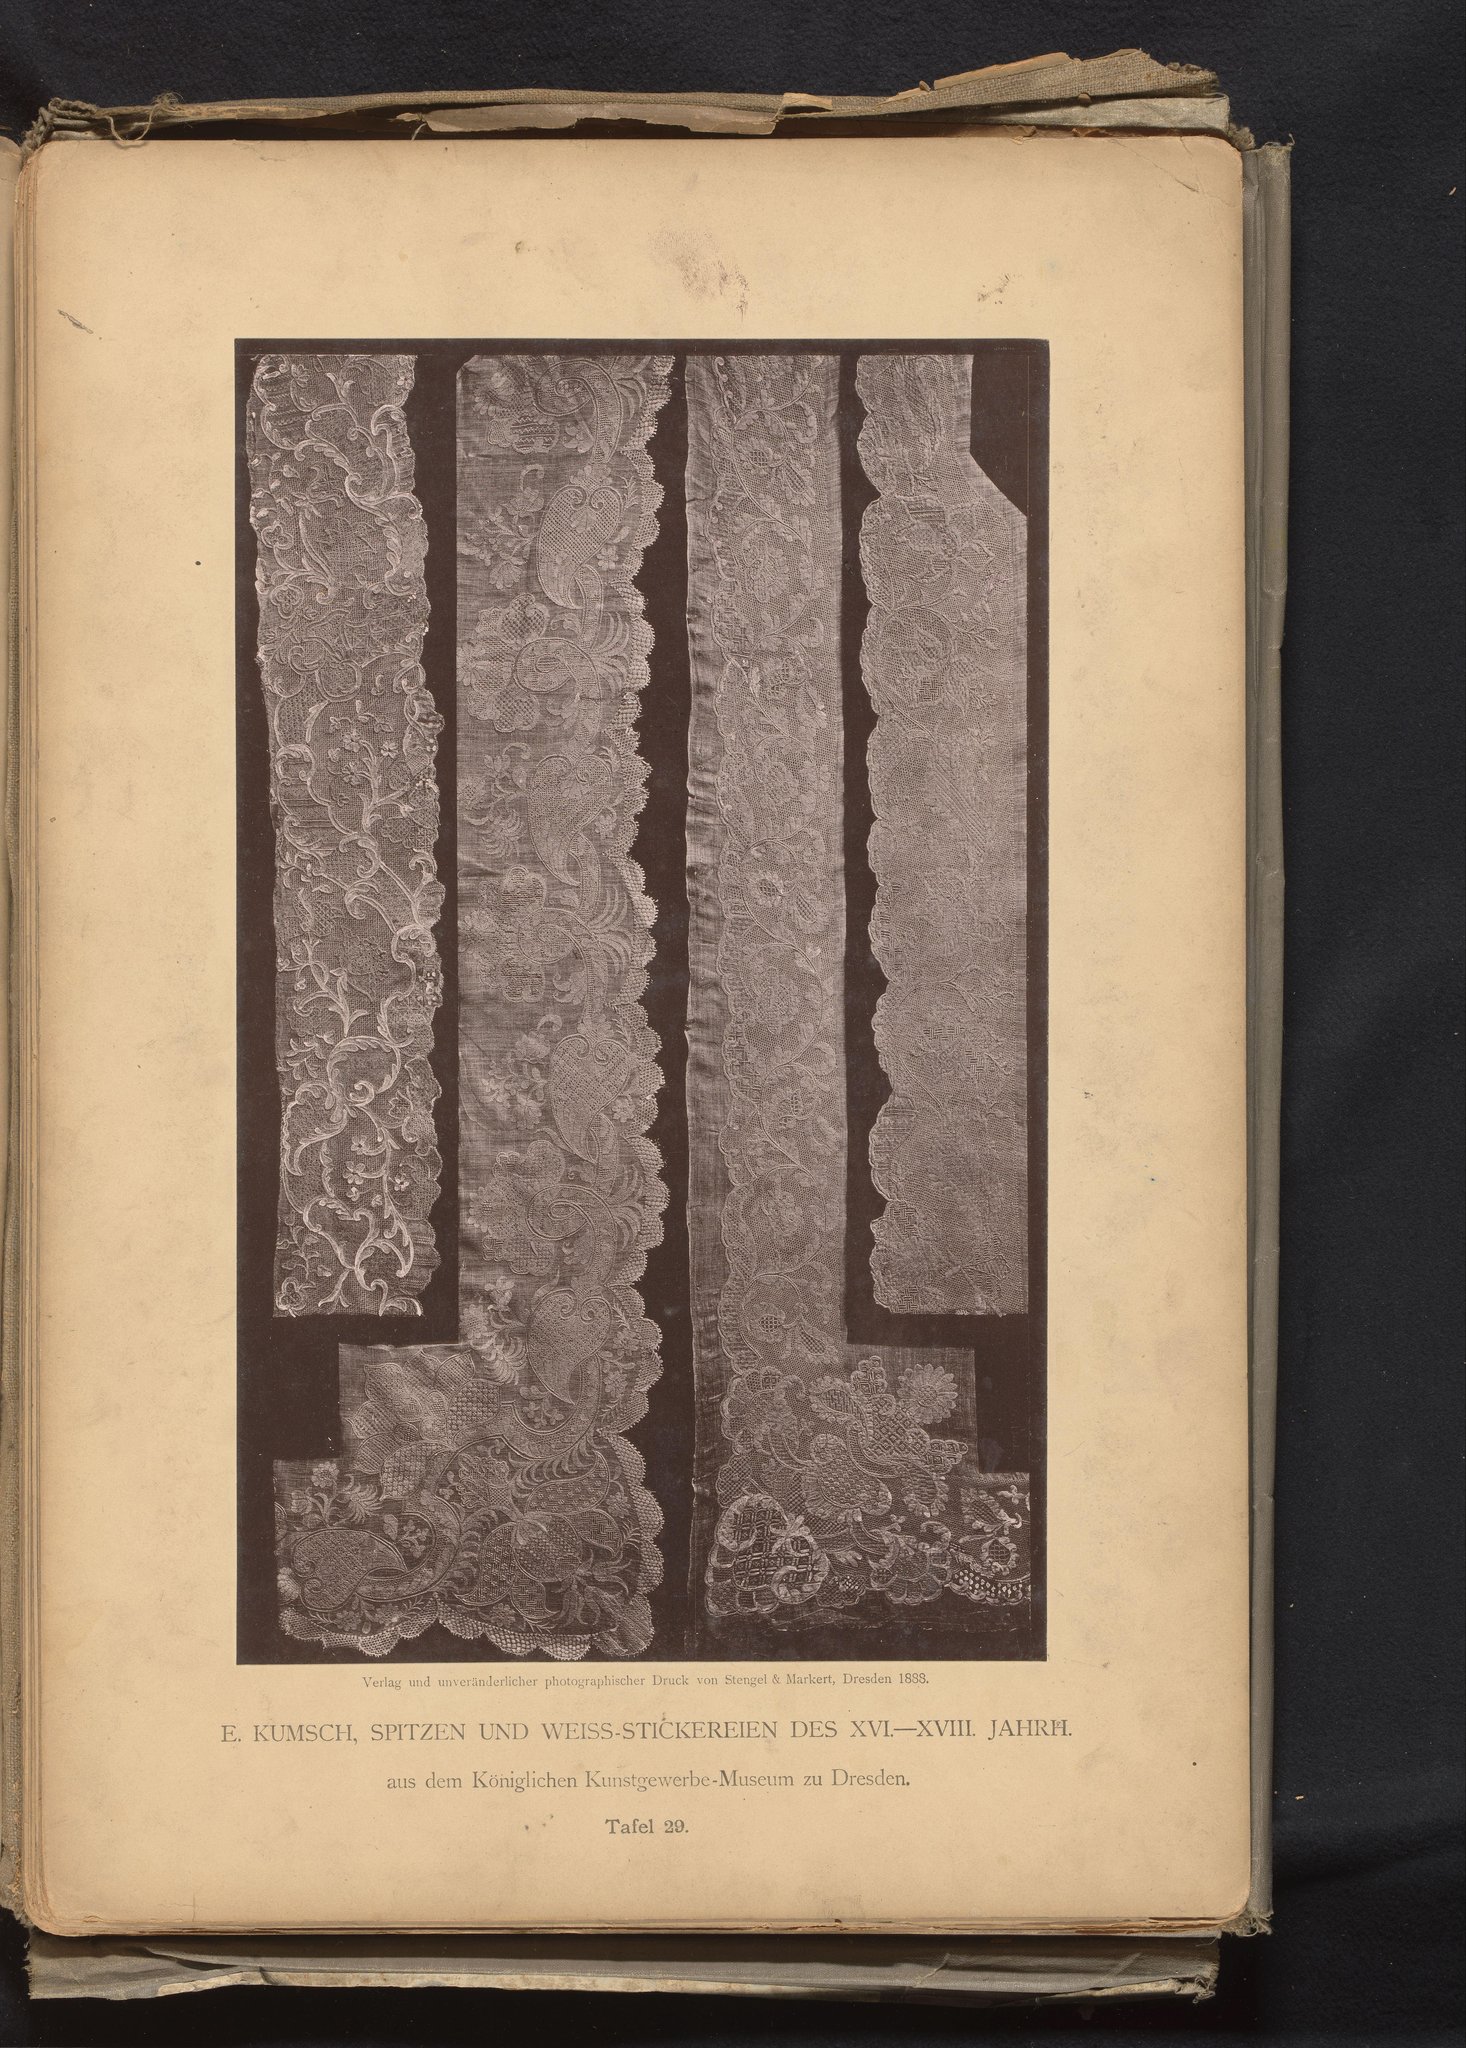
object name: photomechanical print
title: Vier stukken 18de-eeuws Duits kant uit de collectie van het Kunstgewerbemuseum in Dresden, Duitsland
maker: Anonymous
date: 1888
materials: paper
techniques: photograph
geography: dresden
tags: lace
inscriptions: inscription: ‘E. KUMSCH, SPITZEN UND WEISS-STICKEREIEN DES XVI.-XVIII. JAHRH./ aus dem Königlichen Kunstgewerbe-Museum zu Dresden’, number: ‘Tafel 29.’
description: Deze prent maakt deel uit van een omslag met 49 prenten en een lijst van afbeeldingen.